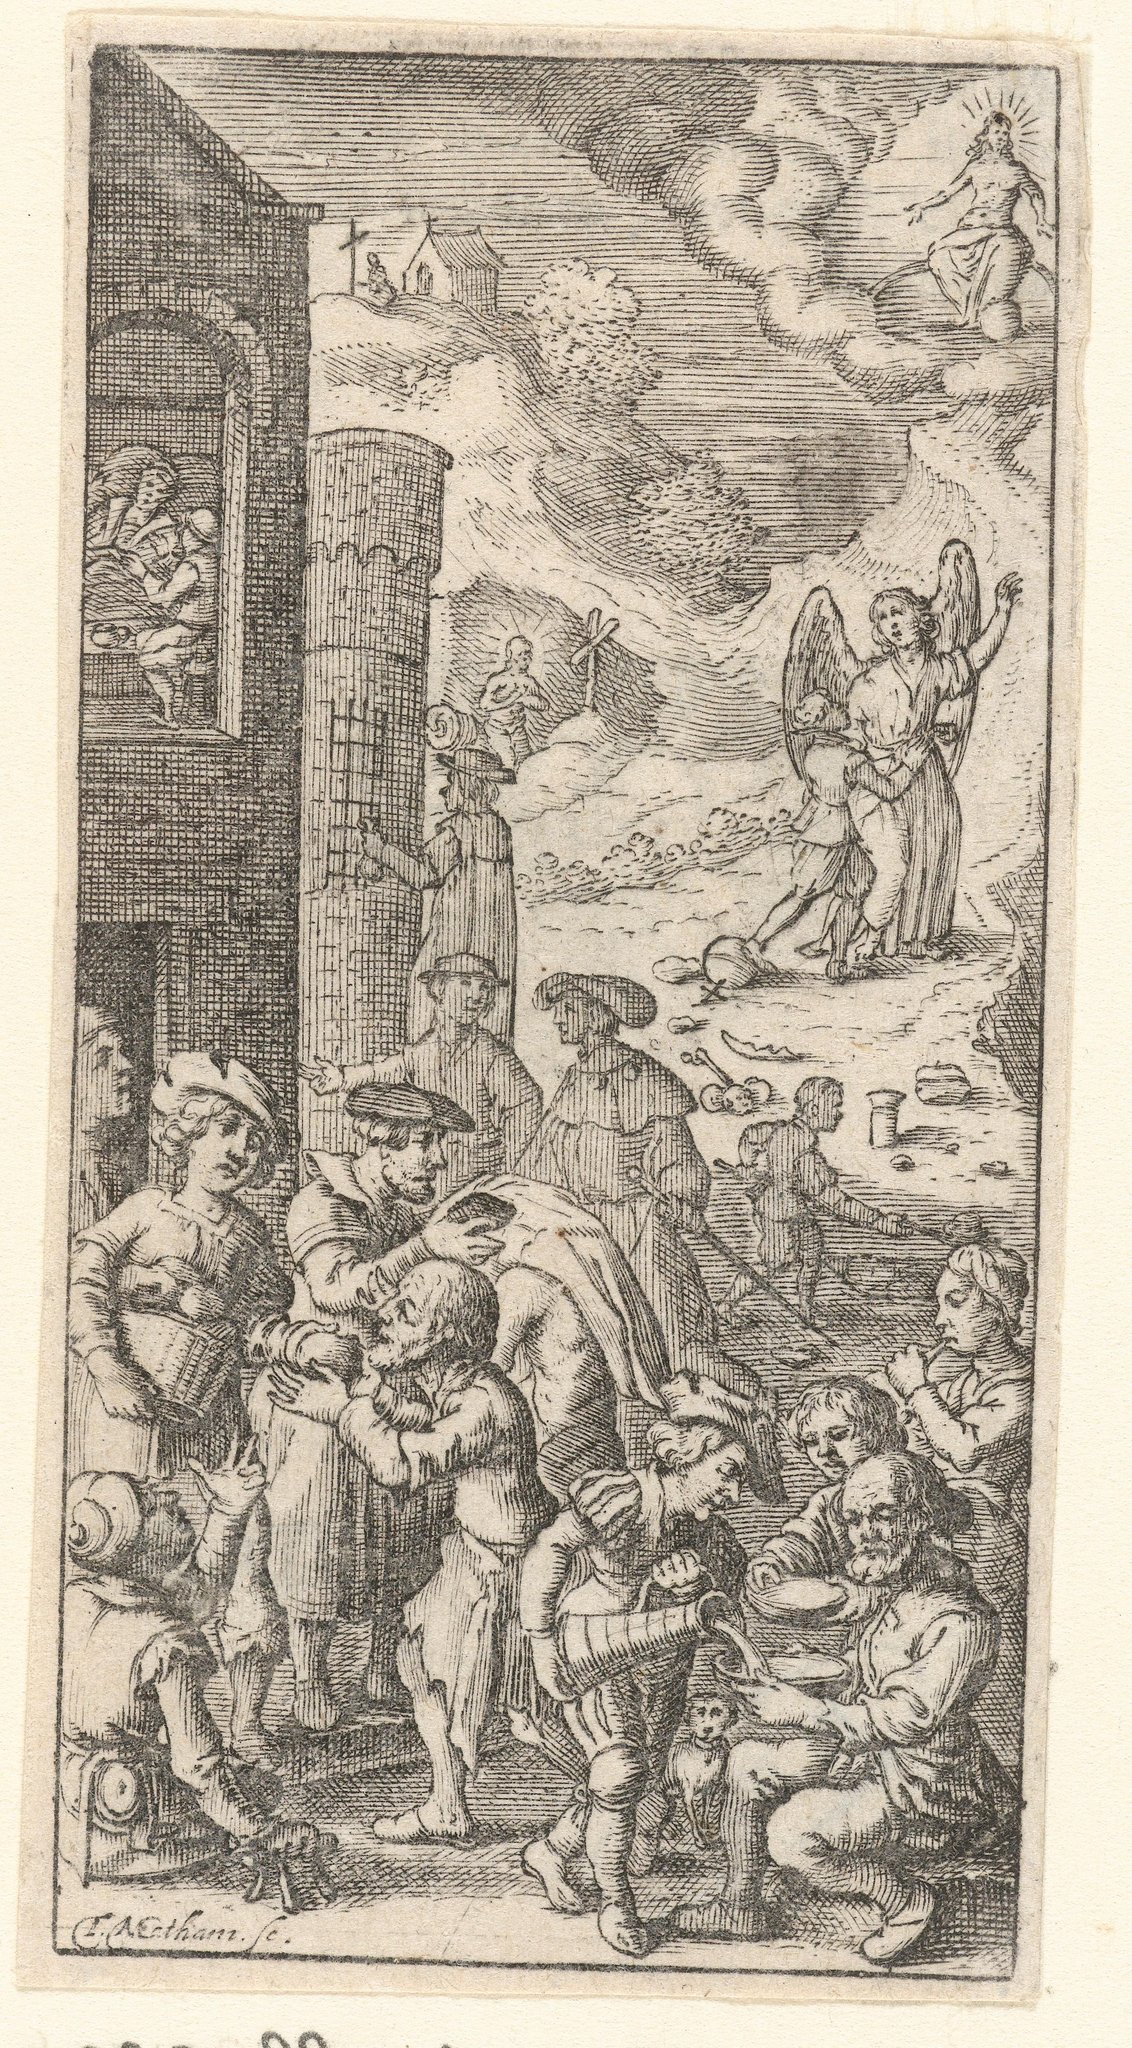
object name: book illustration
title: Werken der barmhartigheid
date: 1626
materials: paper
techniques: engraving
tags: the (seven) acts of mercy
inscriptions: collector's mark: Lugt 2228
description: Het voeden en het kleden der armen op de voorgrond. Links een huis, waar door een raam te zien is hoe een zieke wordt verzorgd. Voor het huis wordt een reiziger onderdak geboden. Rechts op de achtergrond wordt een jongeling door een engel ten hemel geleid, terwijl hij een rijksappel vertrapt.